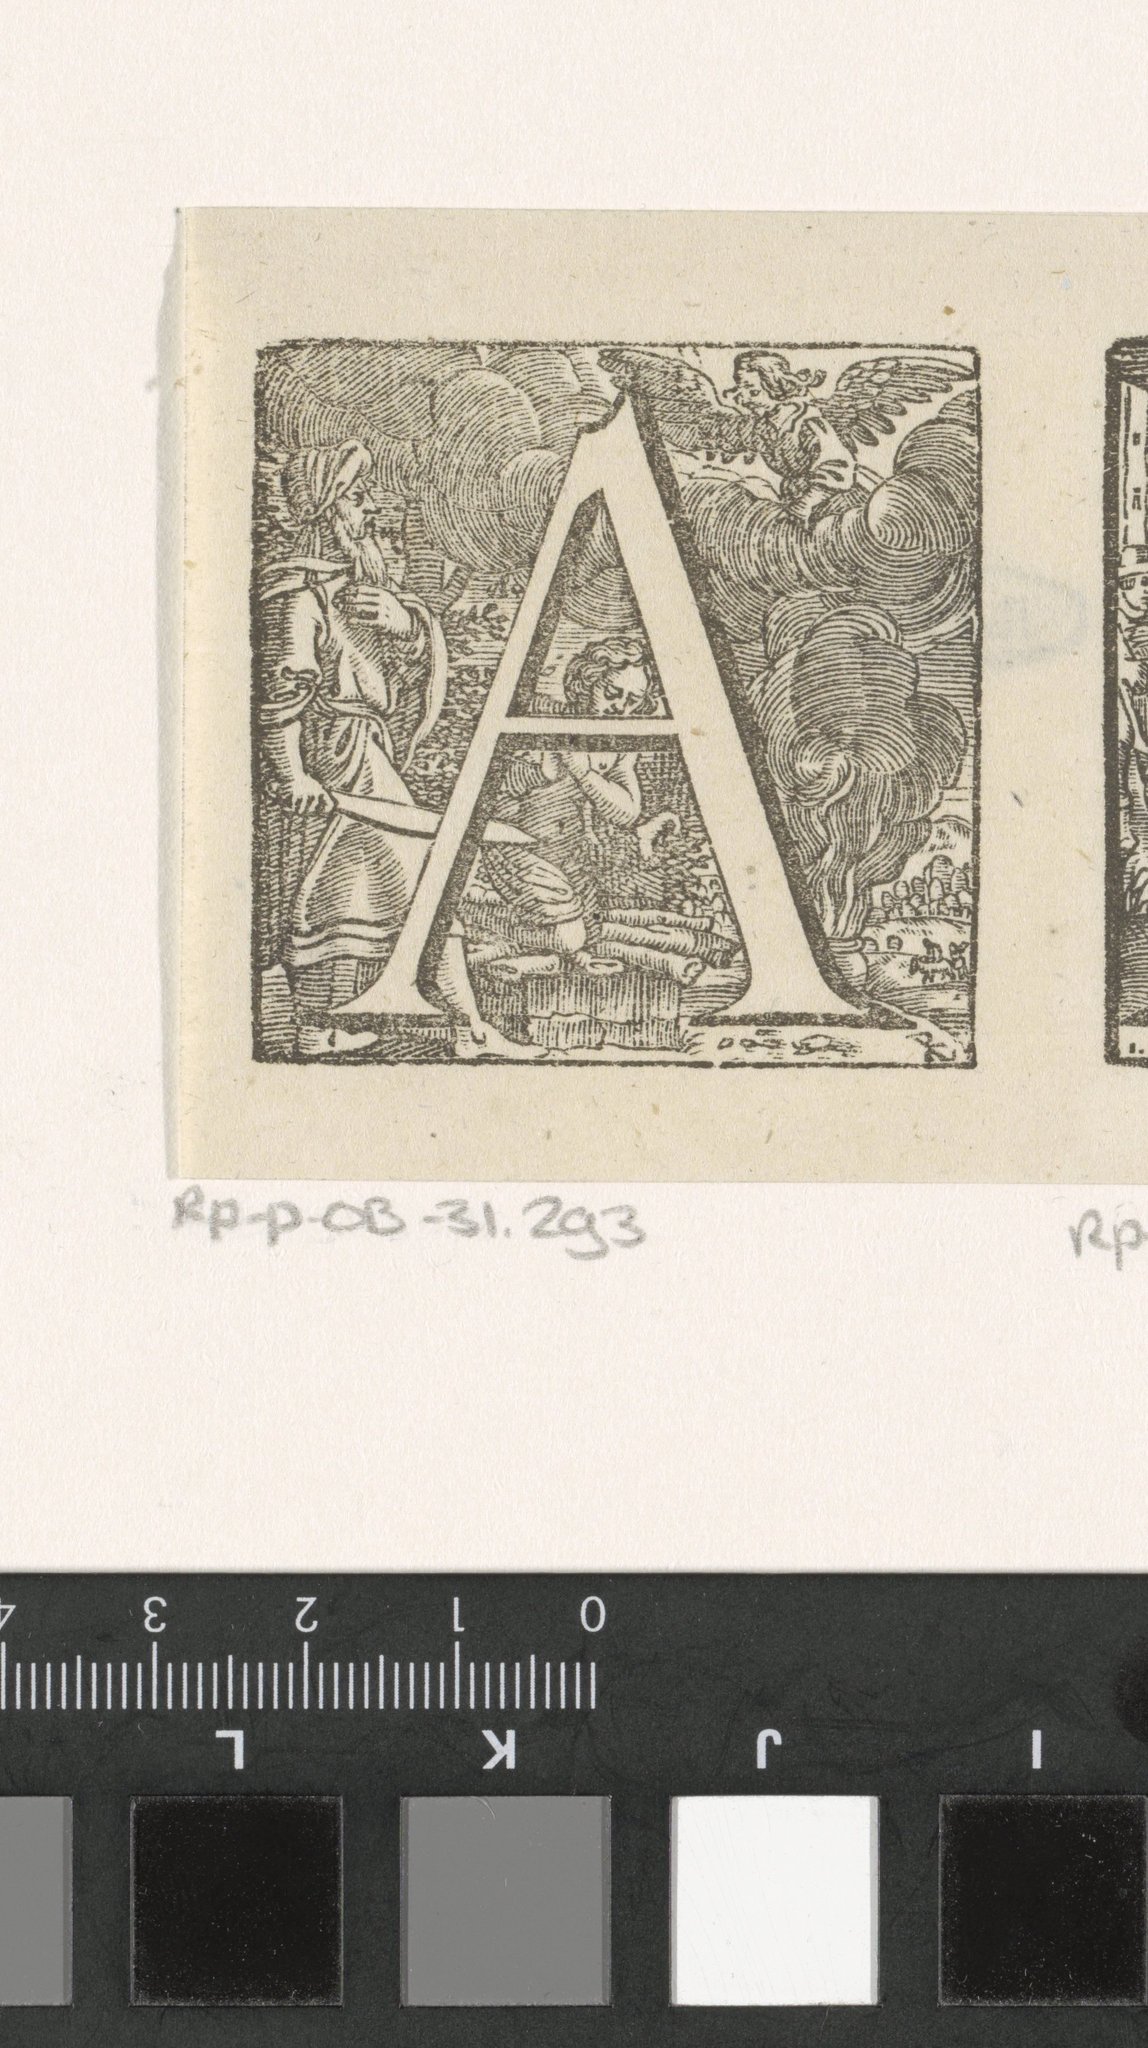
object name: print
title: Letter A in een omlijsting met een voorstelling van Abraham die Isaak offert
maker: monogrammist pc (graveur)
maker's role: print maker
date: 1800-1899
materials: paper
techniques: woodcut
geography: germany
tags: fancy letters, abraham picks up the knife to kill isaac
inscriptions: collector's mark: Lugt 2760, collector's mark: Lugt 2228